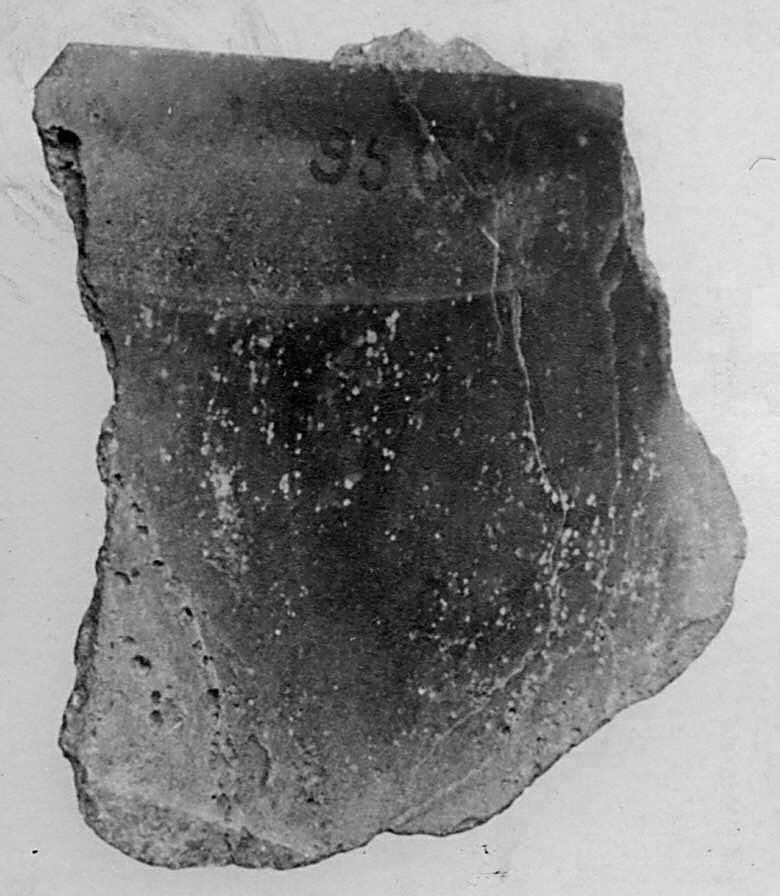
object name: fragment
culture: chinese or turkestani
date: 1902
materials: jade